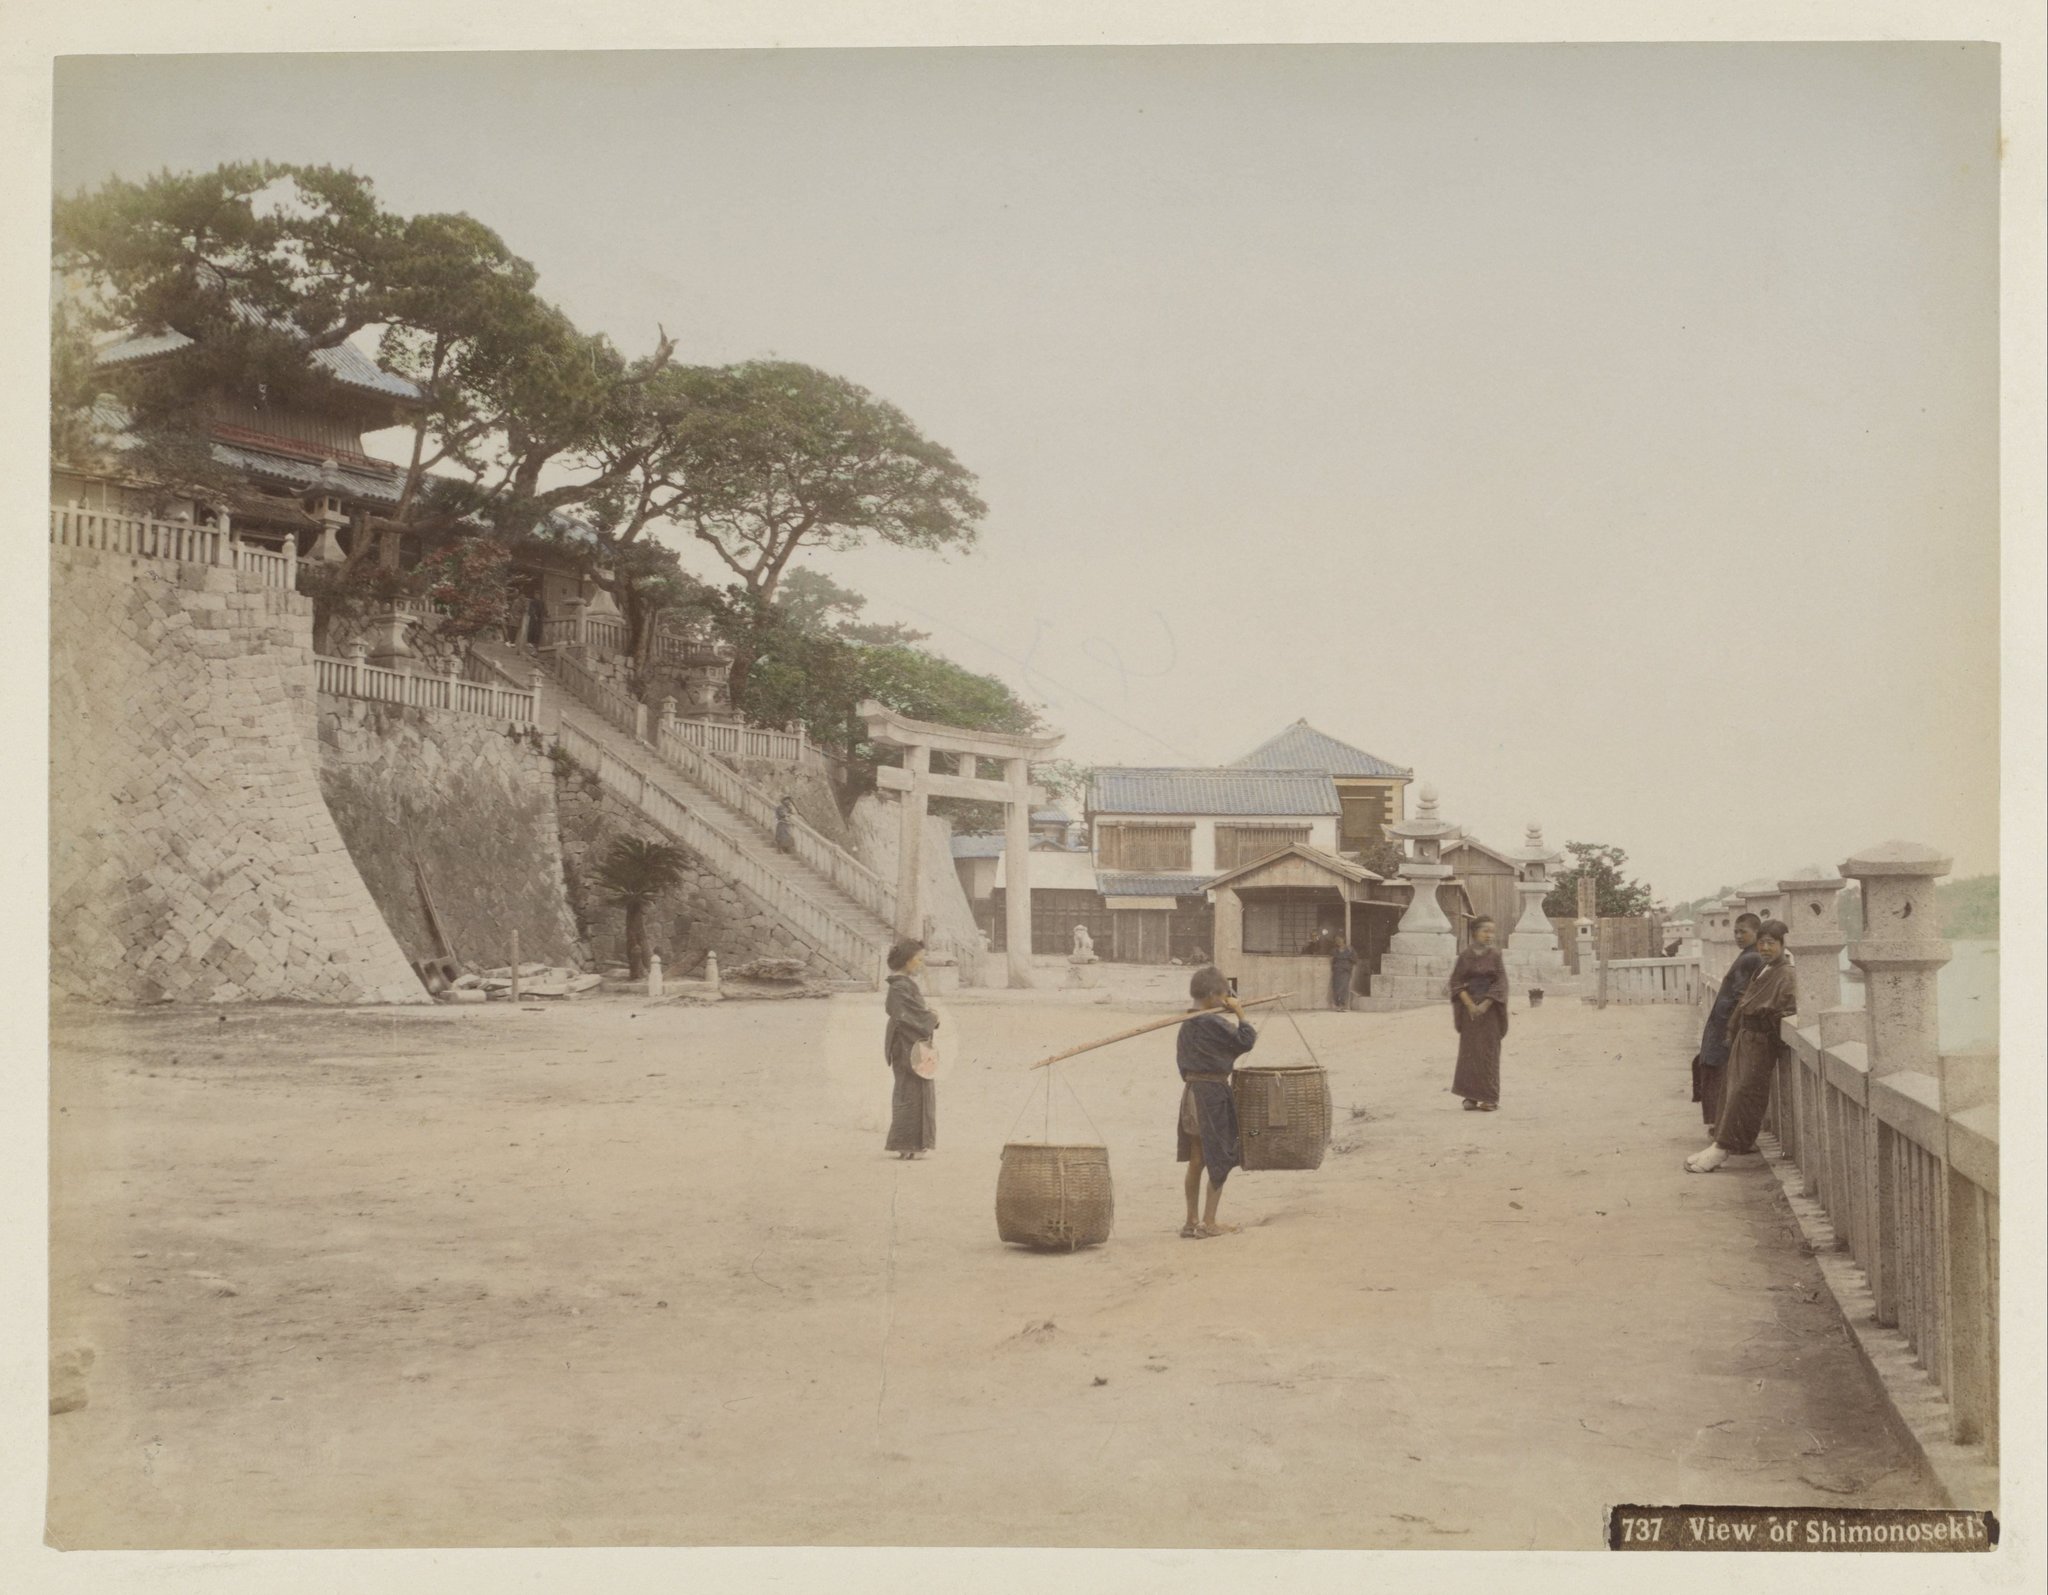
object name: photograph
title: View of Shimonoseki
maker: Anonymous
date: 1870-1900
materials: paper, photographic support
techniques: albumen print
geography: shimonoseki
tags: carrying something with carrying-pole, sloping street; street with steps or stairs, gate, entrance, avenue, boulevard in village, travelling; tourism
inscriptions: negative number: ‘737’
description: Onderdeel van Fotoalbum met 50 foto's van bezienswaardigheden in Japan.